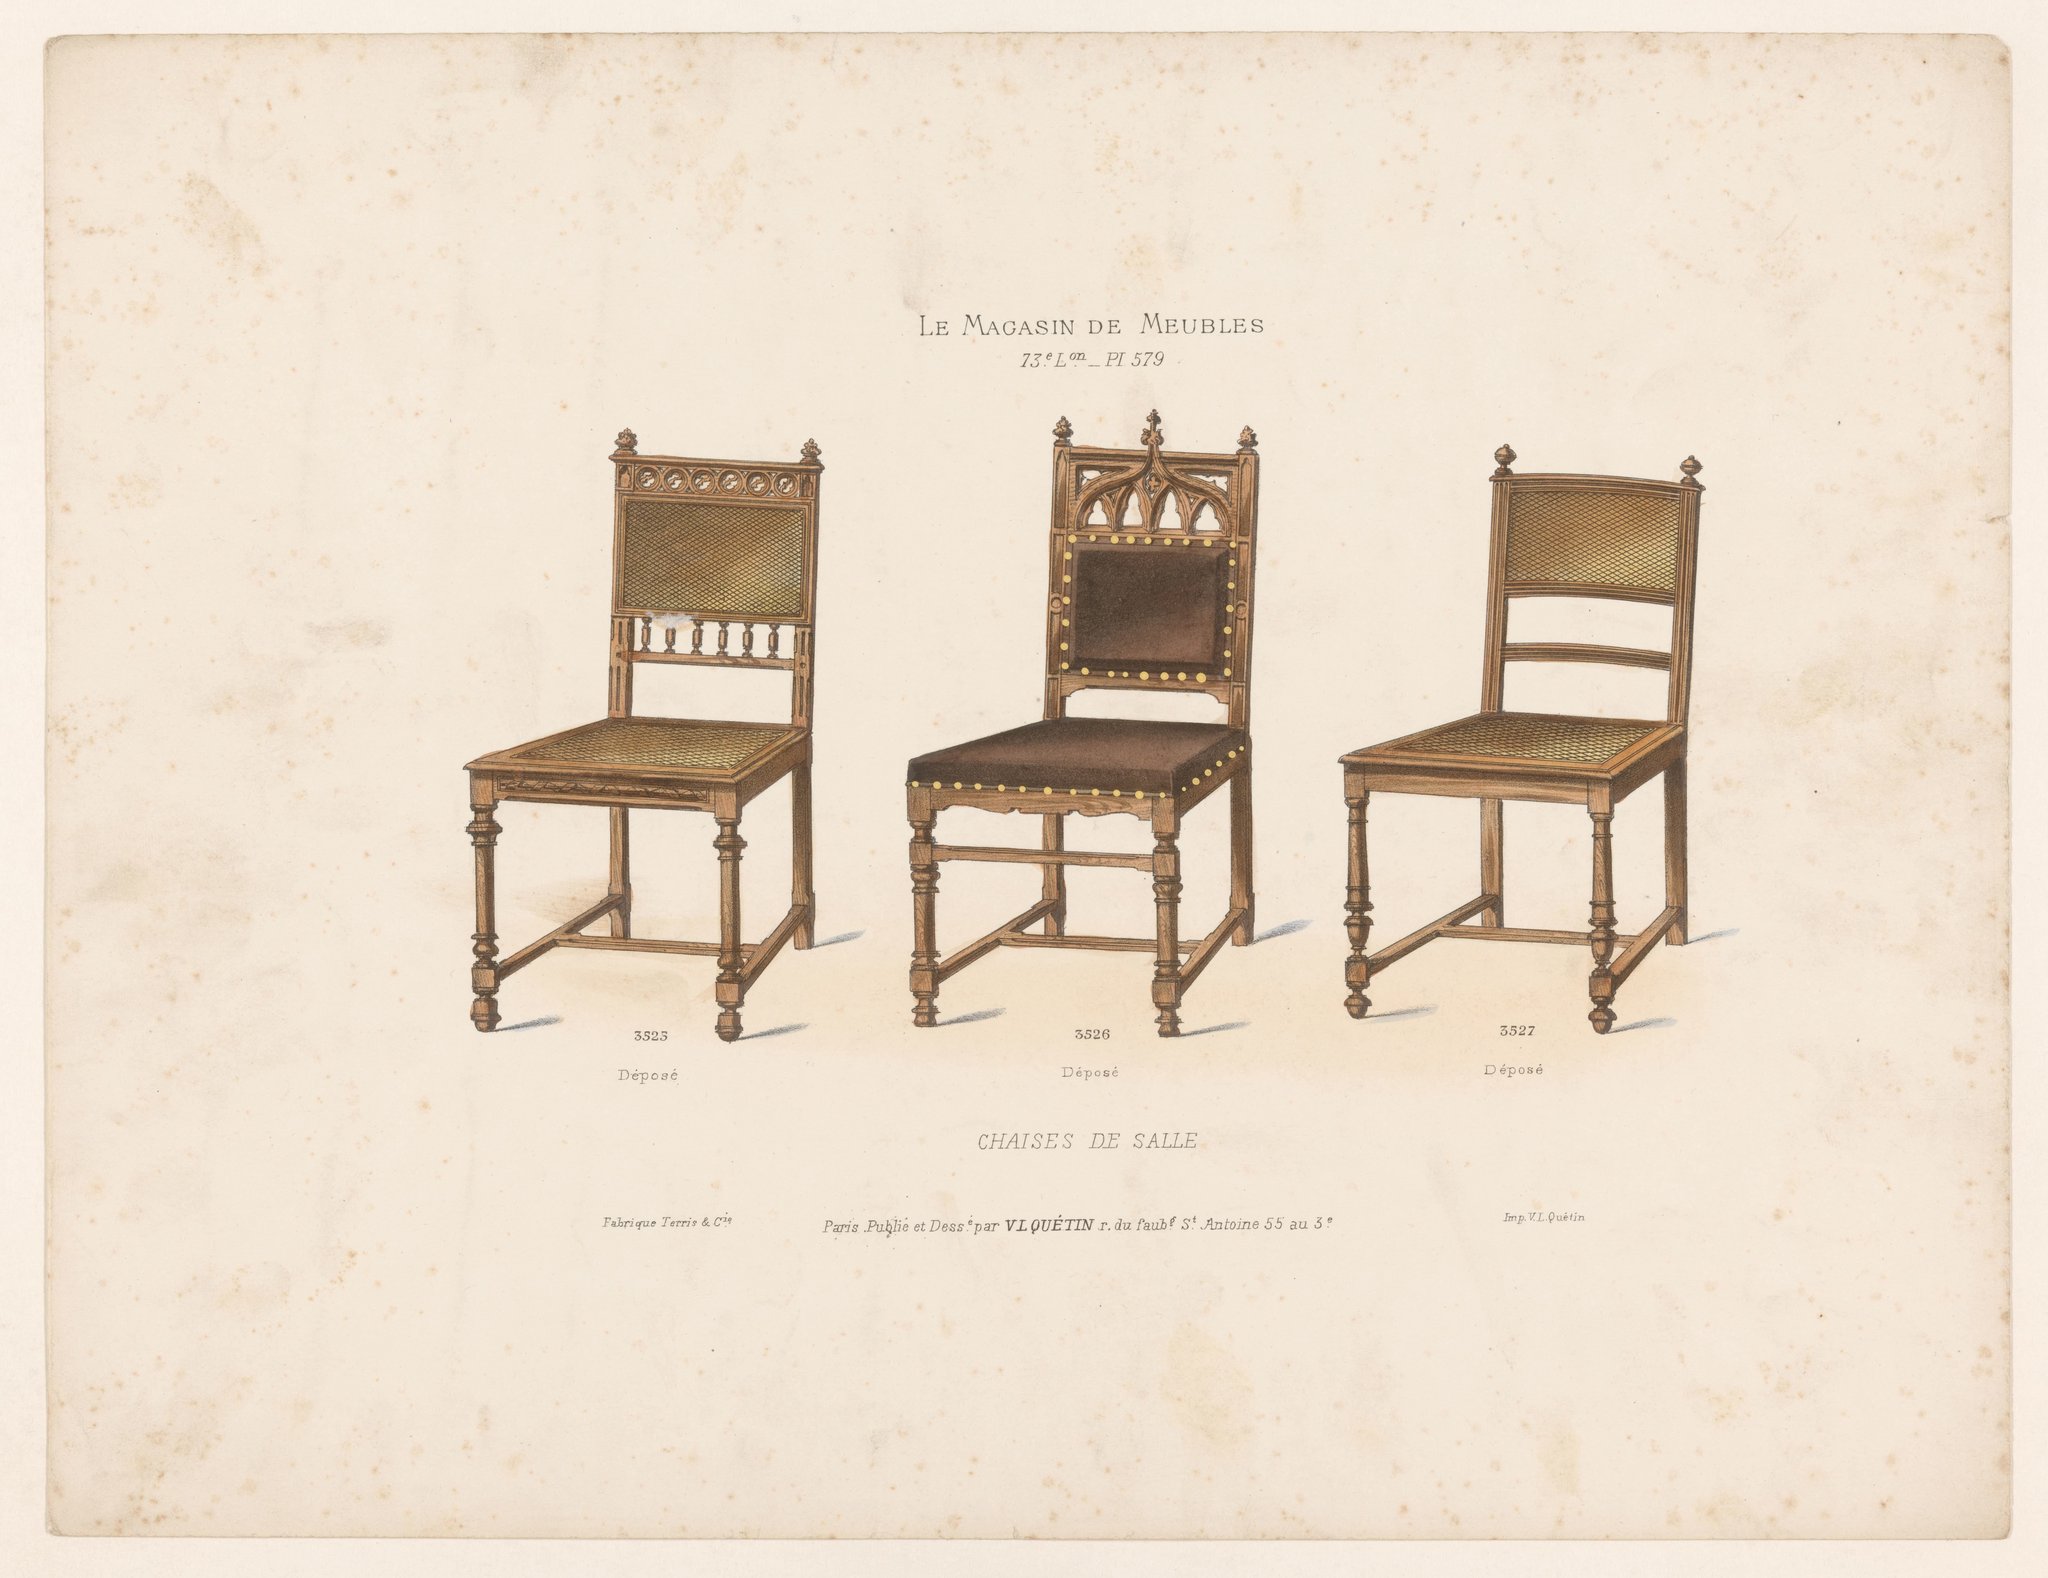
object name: print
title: Drie stoelen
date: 1878-1904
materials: paper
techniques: hand coloring, lithograph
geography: paris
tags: seating furniture